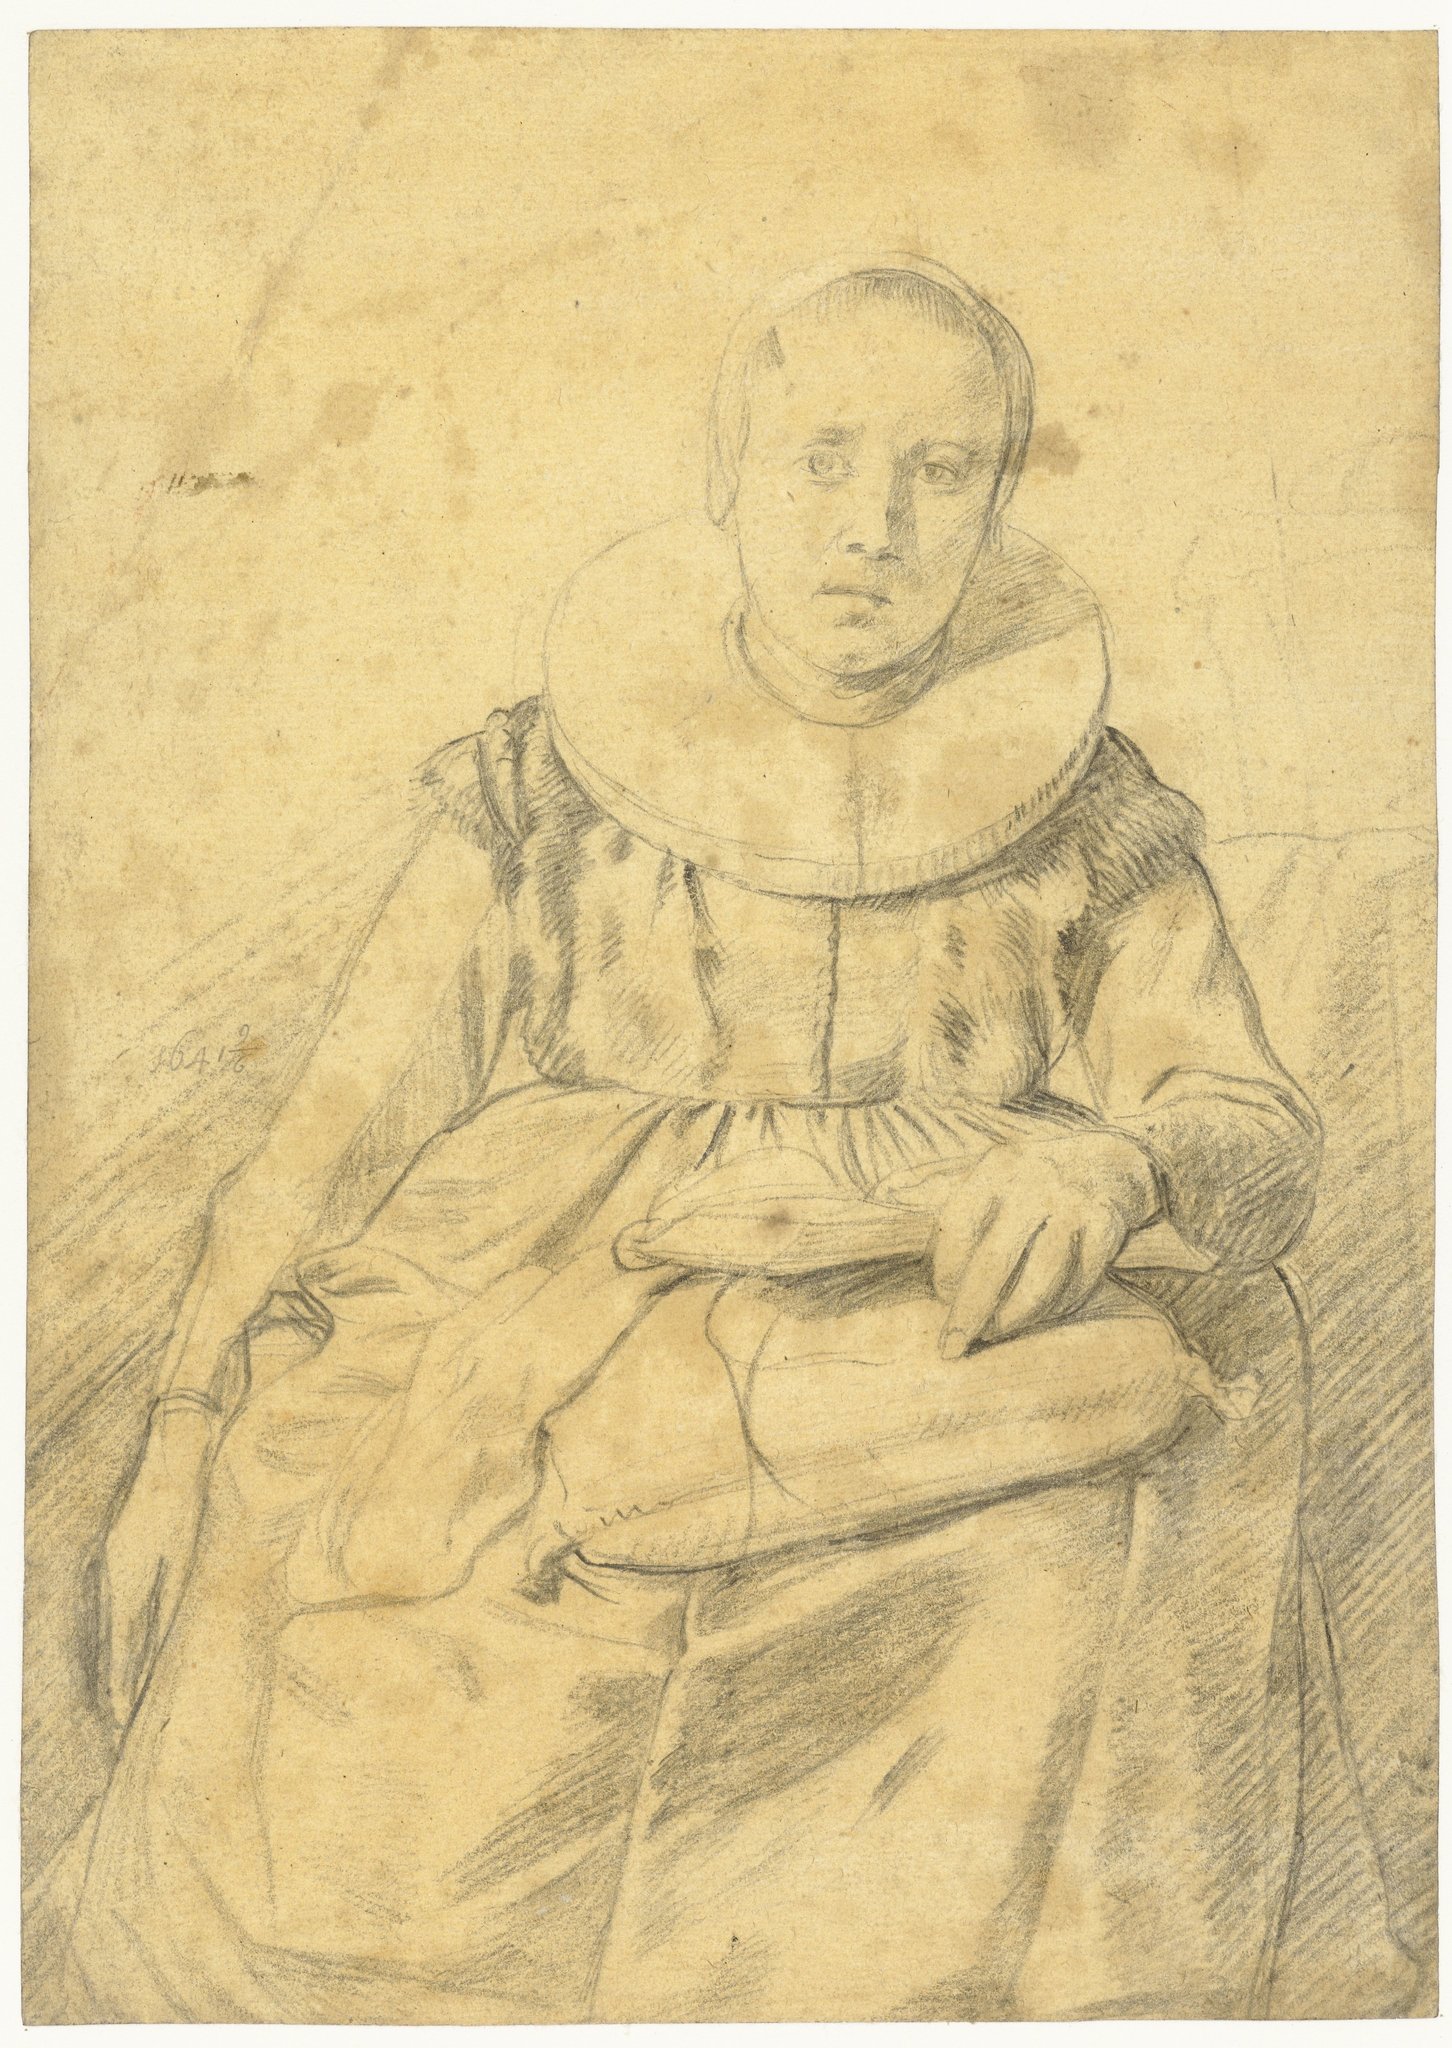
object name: drawing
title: Seated Woman with a Cushion and Book on her Lap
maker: salomon de bray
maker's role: draughtsman, print maker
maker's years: 1597-1664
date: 1641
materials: chalk, paper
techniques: drawing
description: Portret van een zittende vrouw met een boek op een kussen op haar schoot.